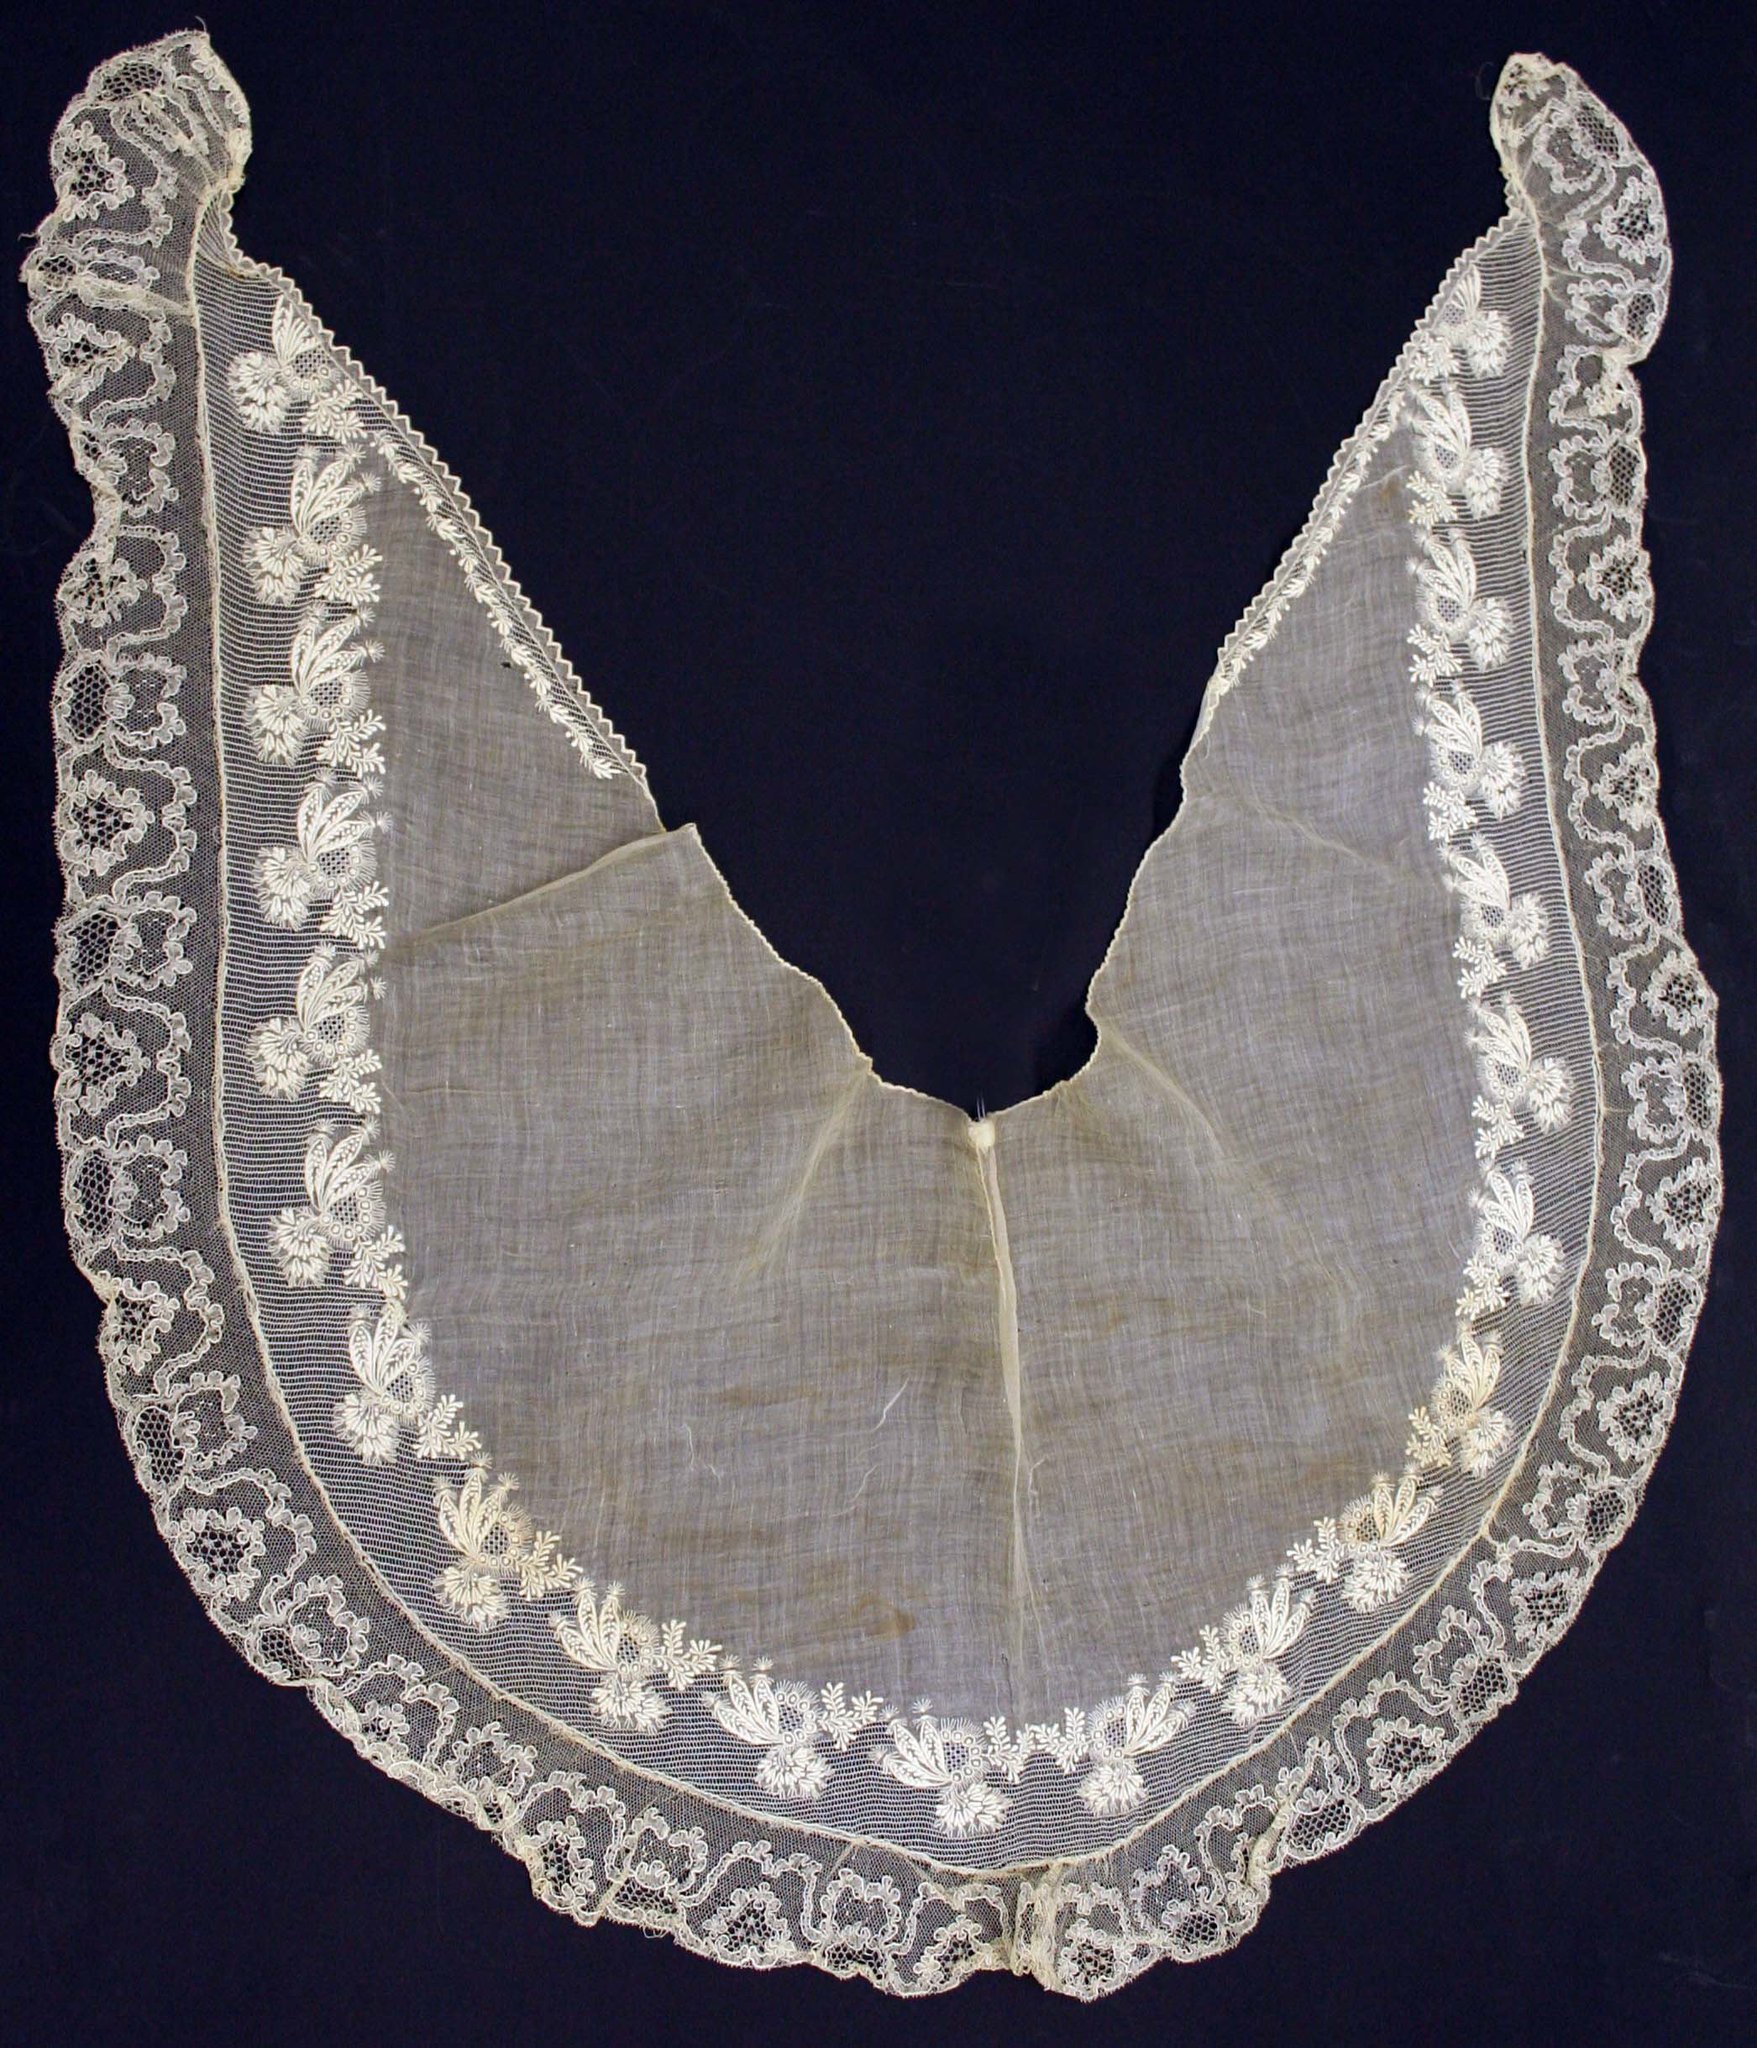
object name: fichu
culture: american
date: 1855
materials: cotton